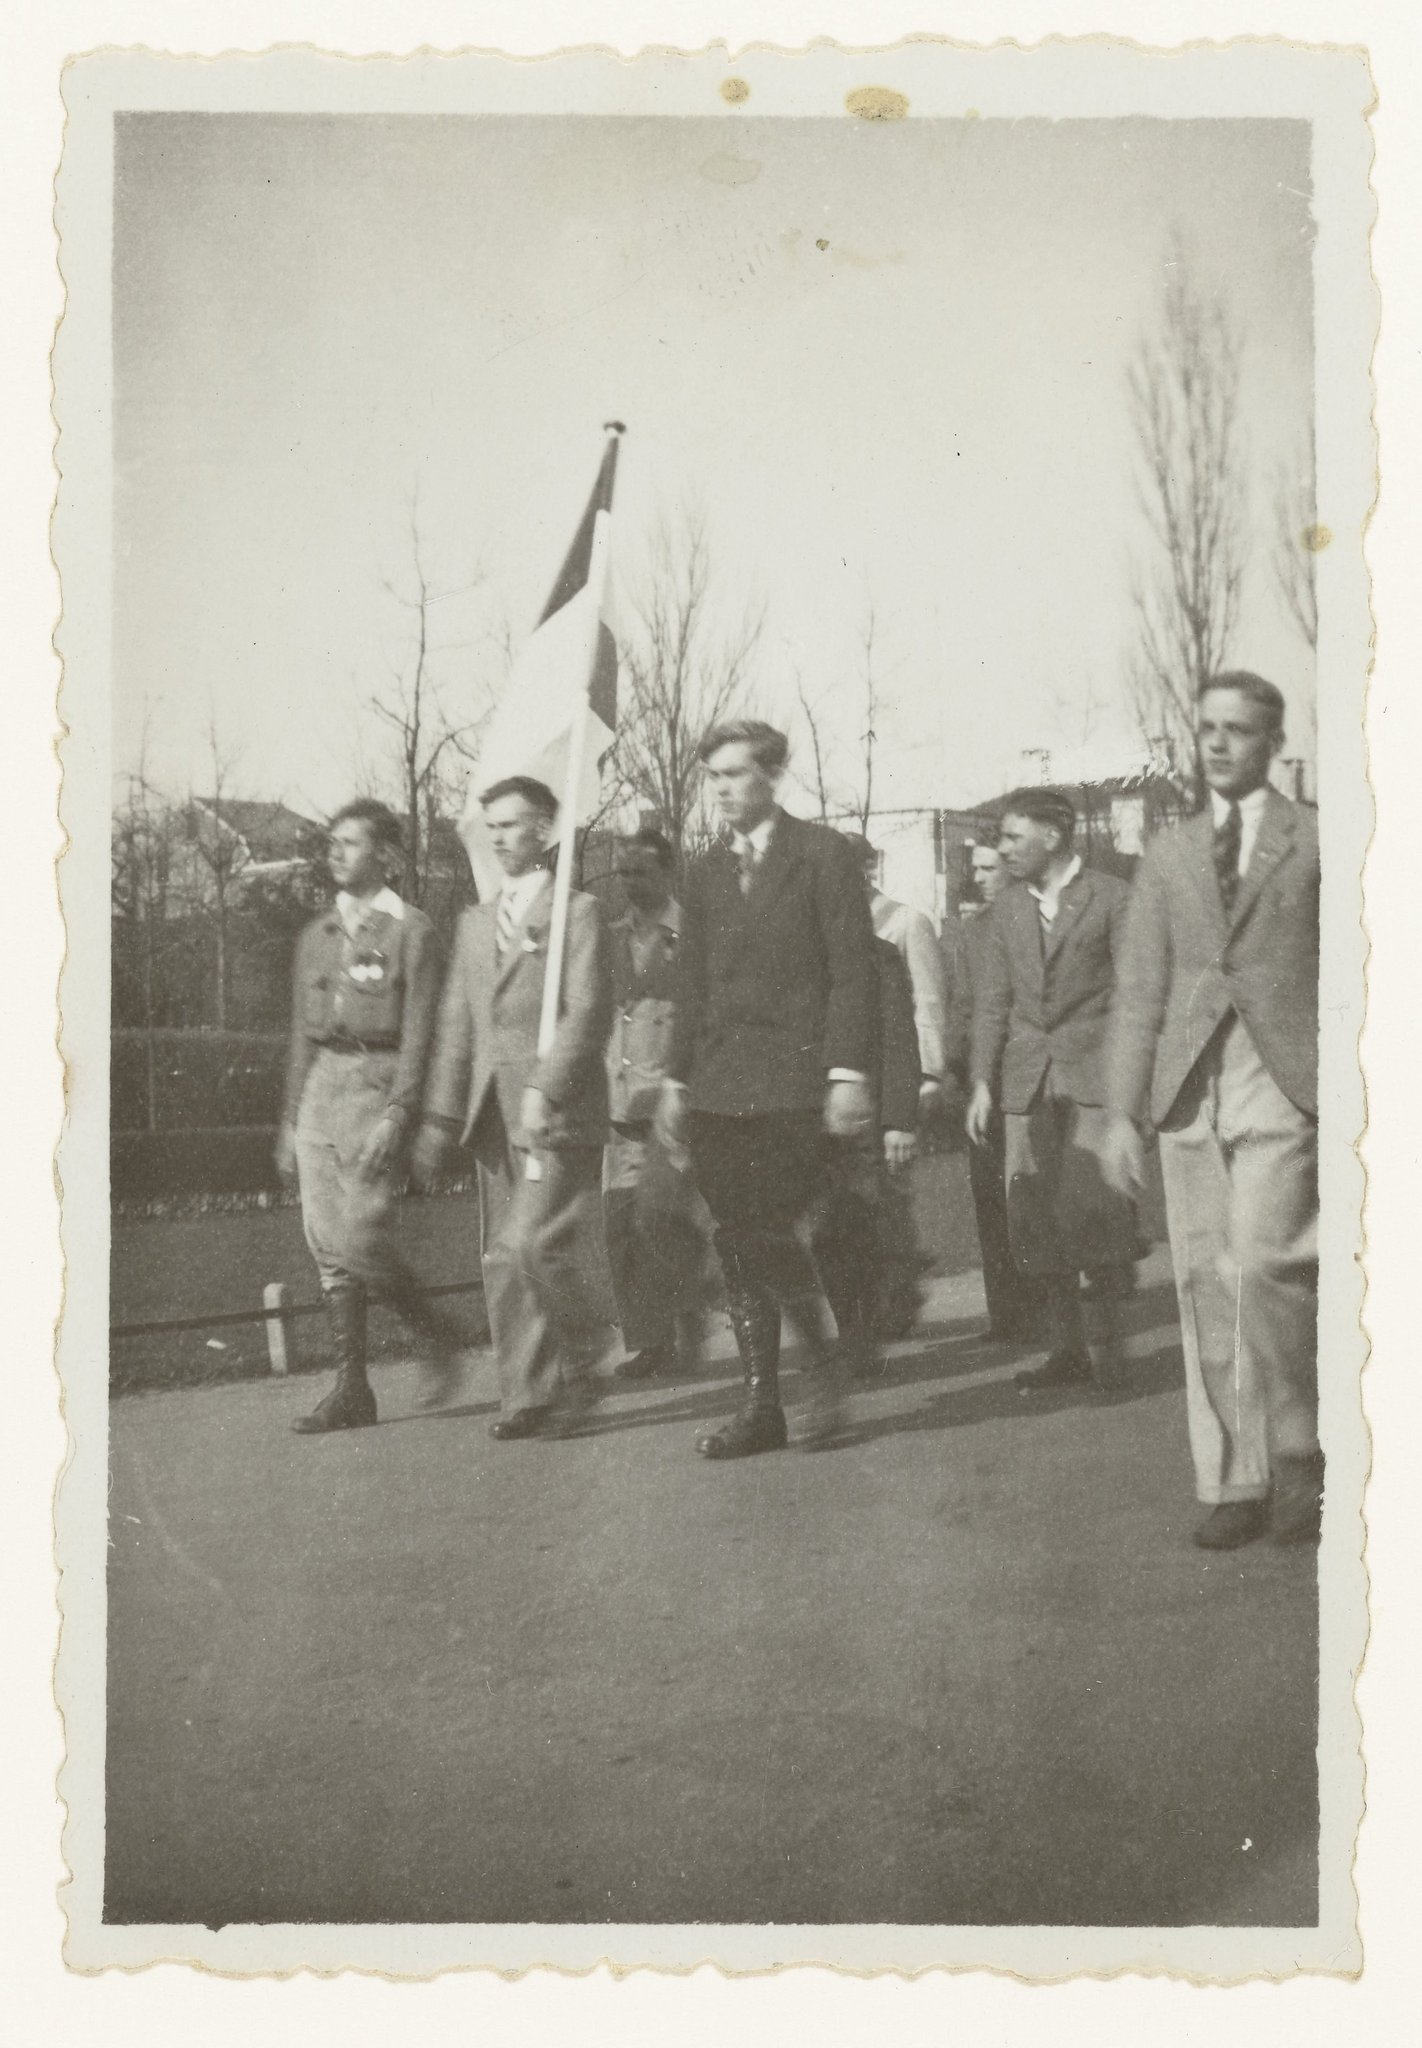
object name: photograph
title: Optocht NSB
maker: Anonymous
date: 1936-1937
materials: photographic support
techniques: gelatin silver print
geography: utrecht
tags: military parade, pageant, amsterdam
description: Optocht van de NSB. Voorop een man met de Nederlandse vlag en links van hem een man in een lichte overall met op zijn borst een soort medailles. Niemand is in uniform. Vanaf 1936 gold voor de NSB en aan hen verwante organisaties een verbod om in uniform op straat te verschijnen.